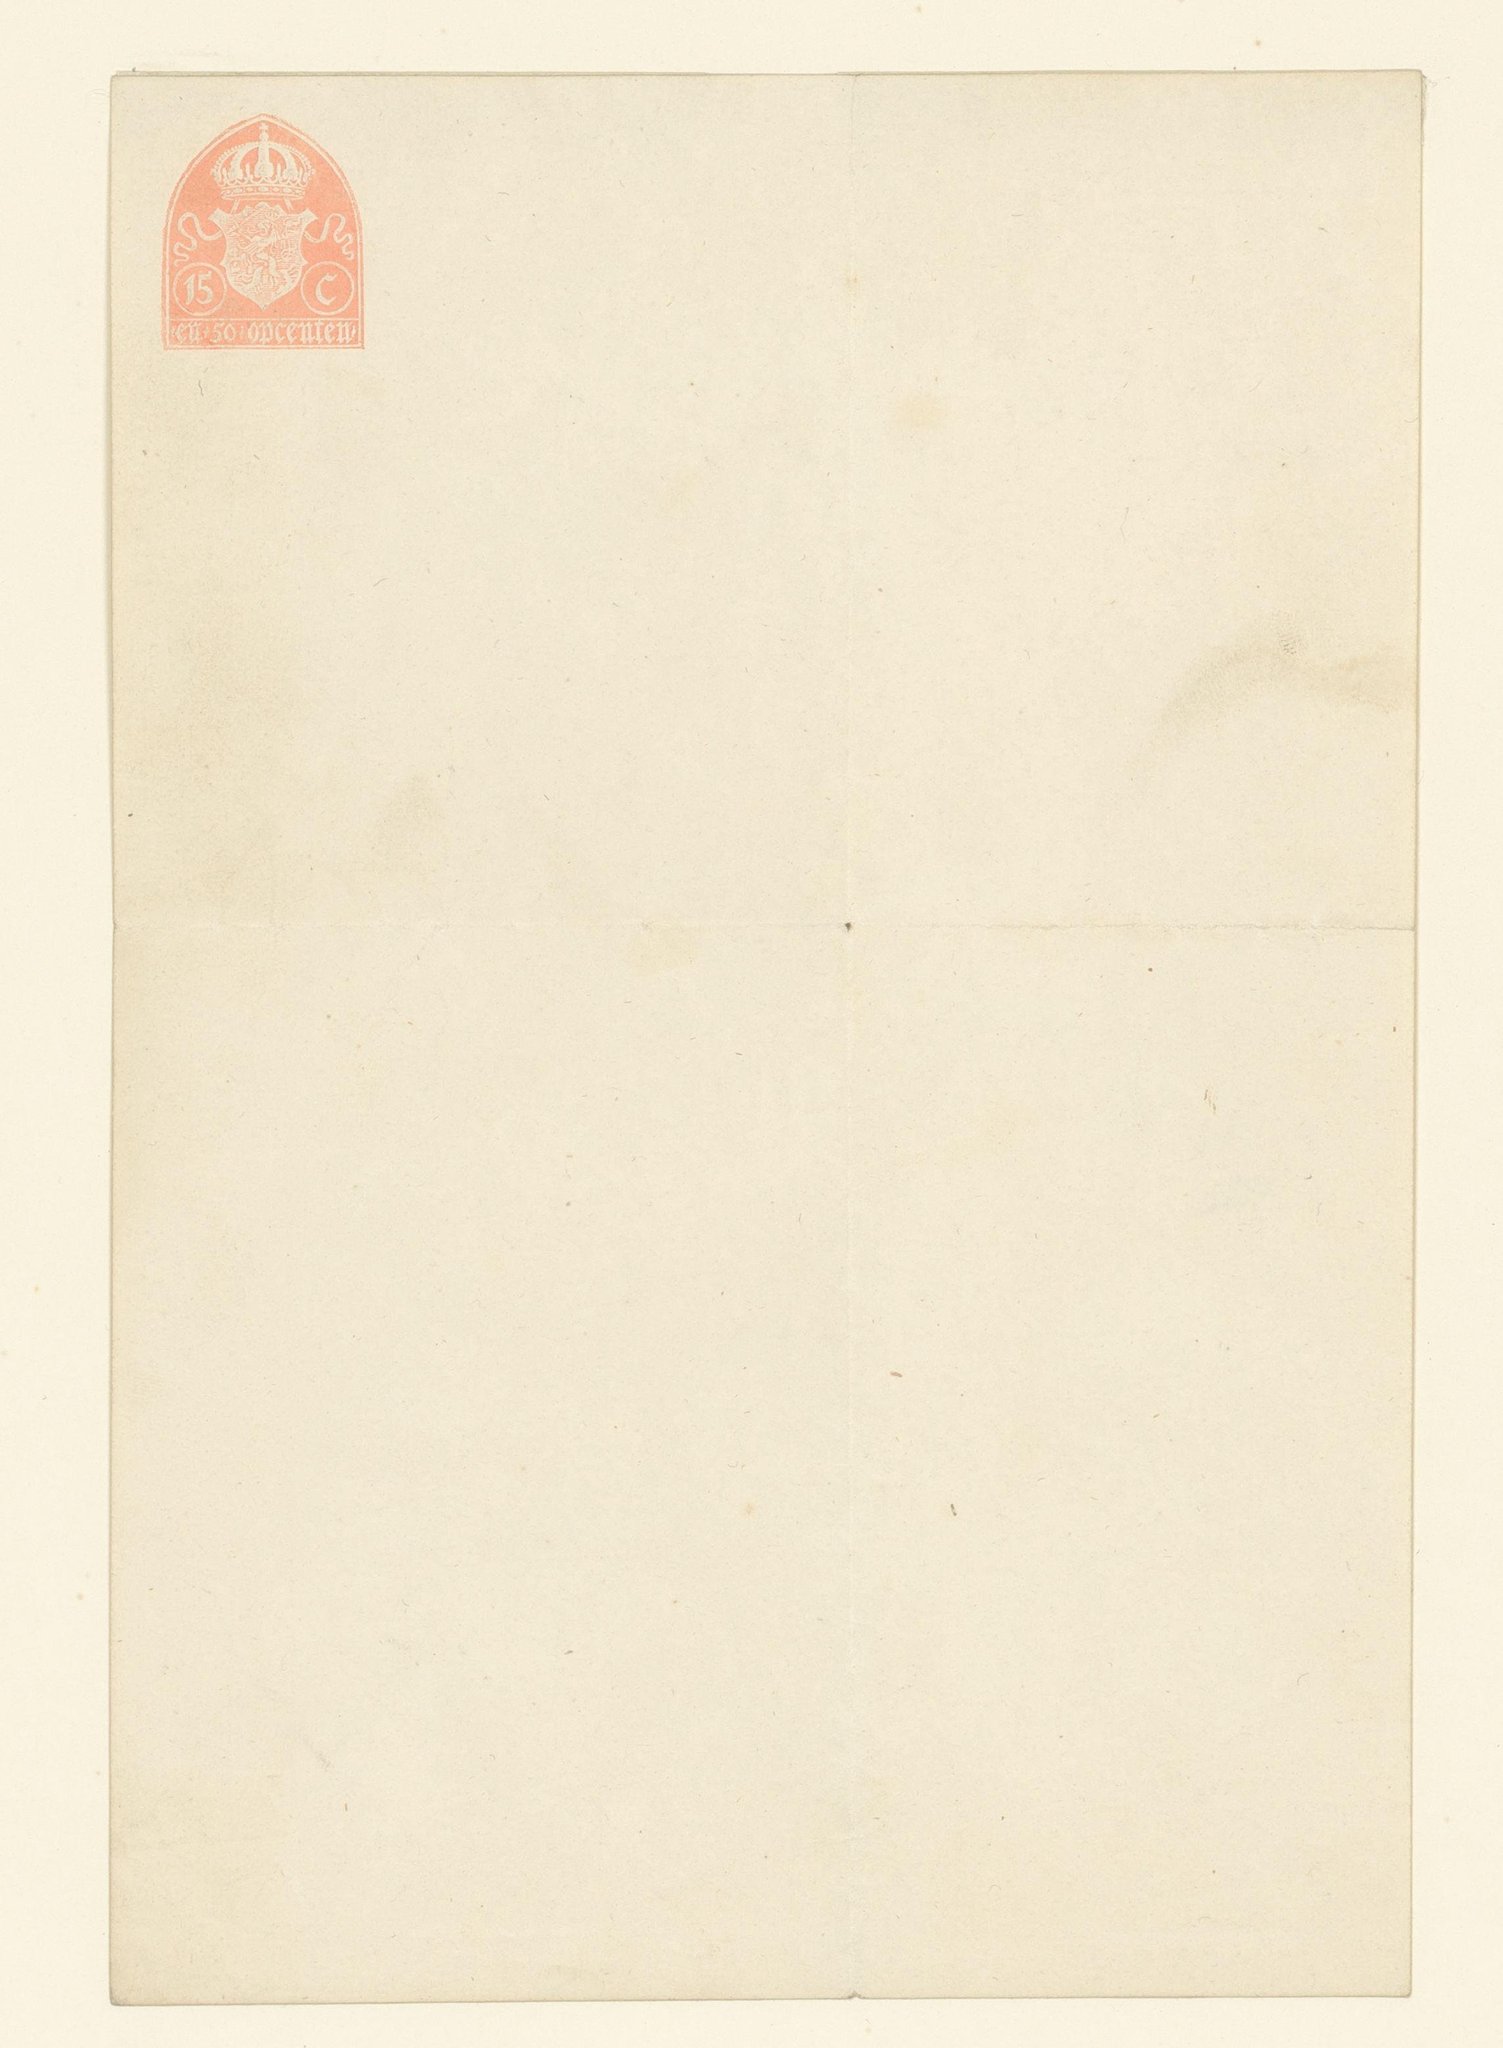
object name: document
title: Briefpapier met belastingzegel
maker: Anonymous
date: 1890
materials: paper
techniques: blind stamped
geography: netherlands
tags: stamp (~ postal matter), tax collection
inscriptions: collector's mark, collector's mark: Lugt 1641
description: Briefpapier met een voorgestelde maar nooit ingevoerde belastingzegel van 15 cent en 50 opcenten. Onderwerpsrubrieken binnen de Atlas Zeden en Gewoonten: Regeering, Belasting.